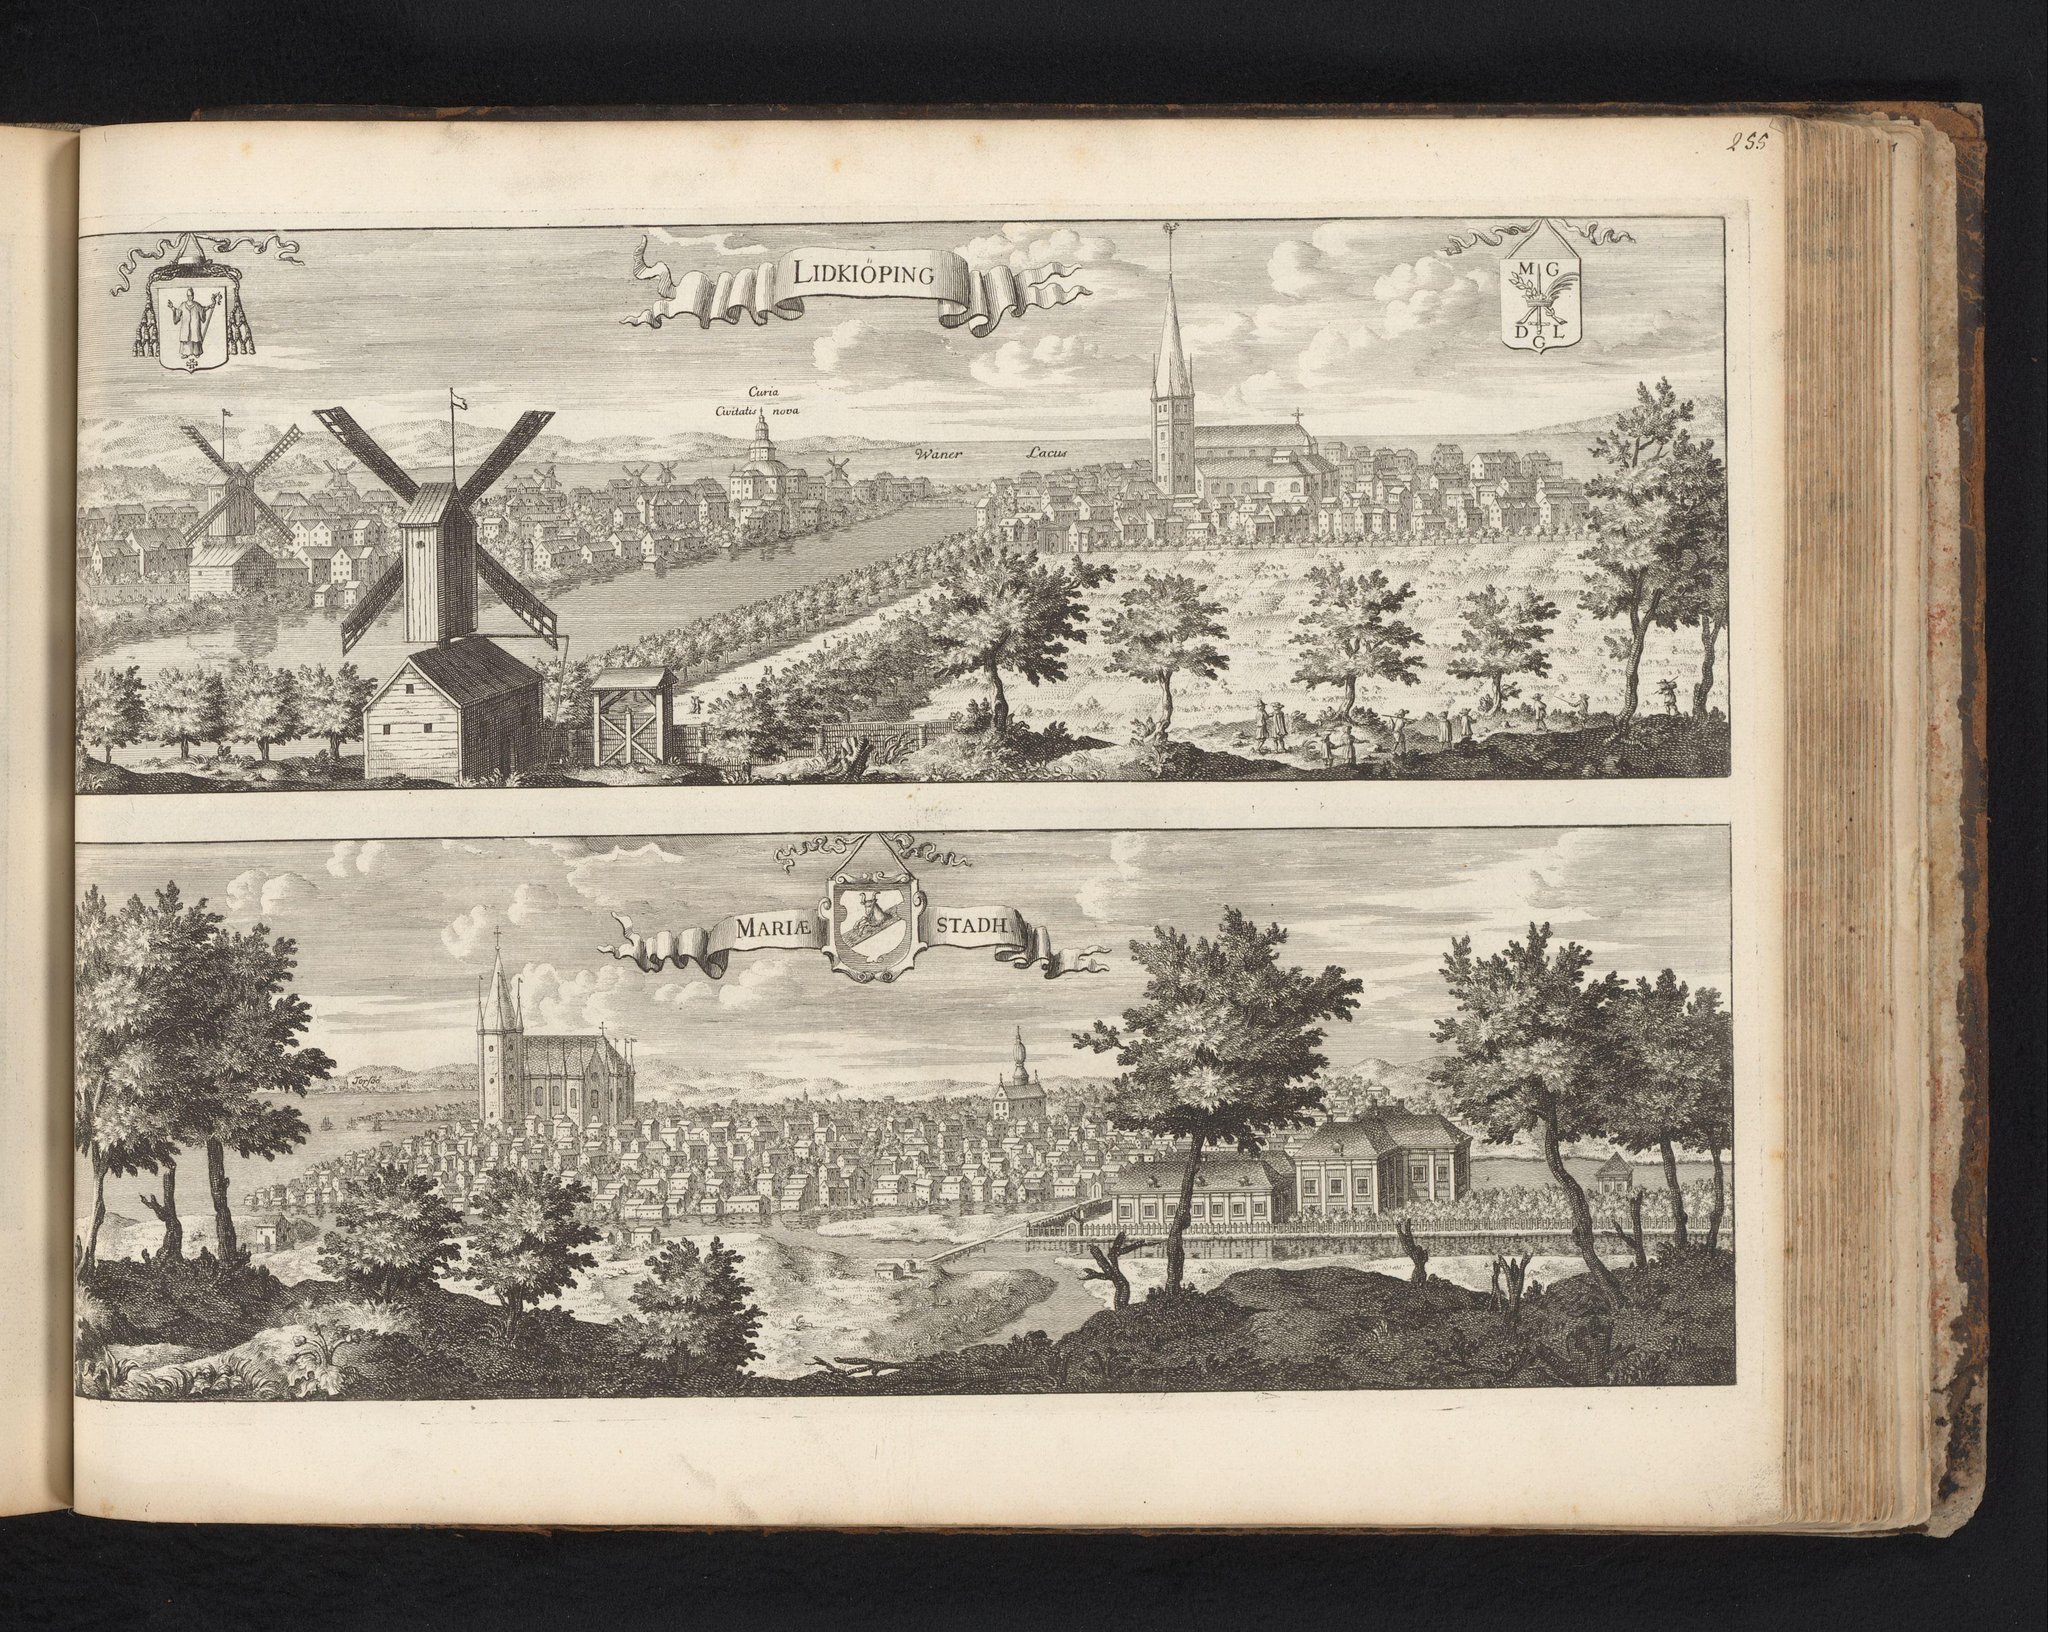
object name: album leaf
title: Lidkiöping / Mariaestadh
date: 1697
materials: paper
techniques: etching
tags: city-view in general; 'veduta'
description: Kungliga Biblioteket, 'Suecia': http://www.kb.se/samlingarna/Kartor-bilder/Suecia-antiqua/ (geraadpleegd november 2016).